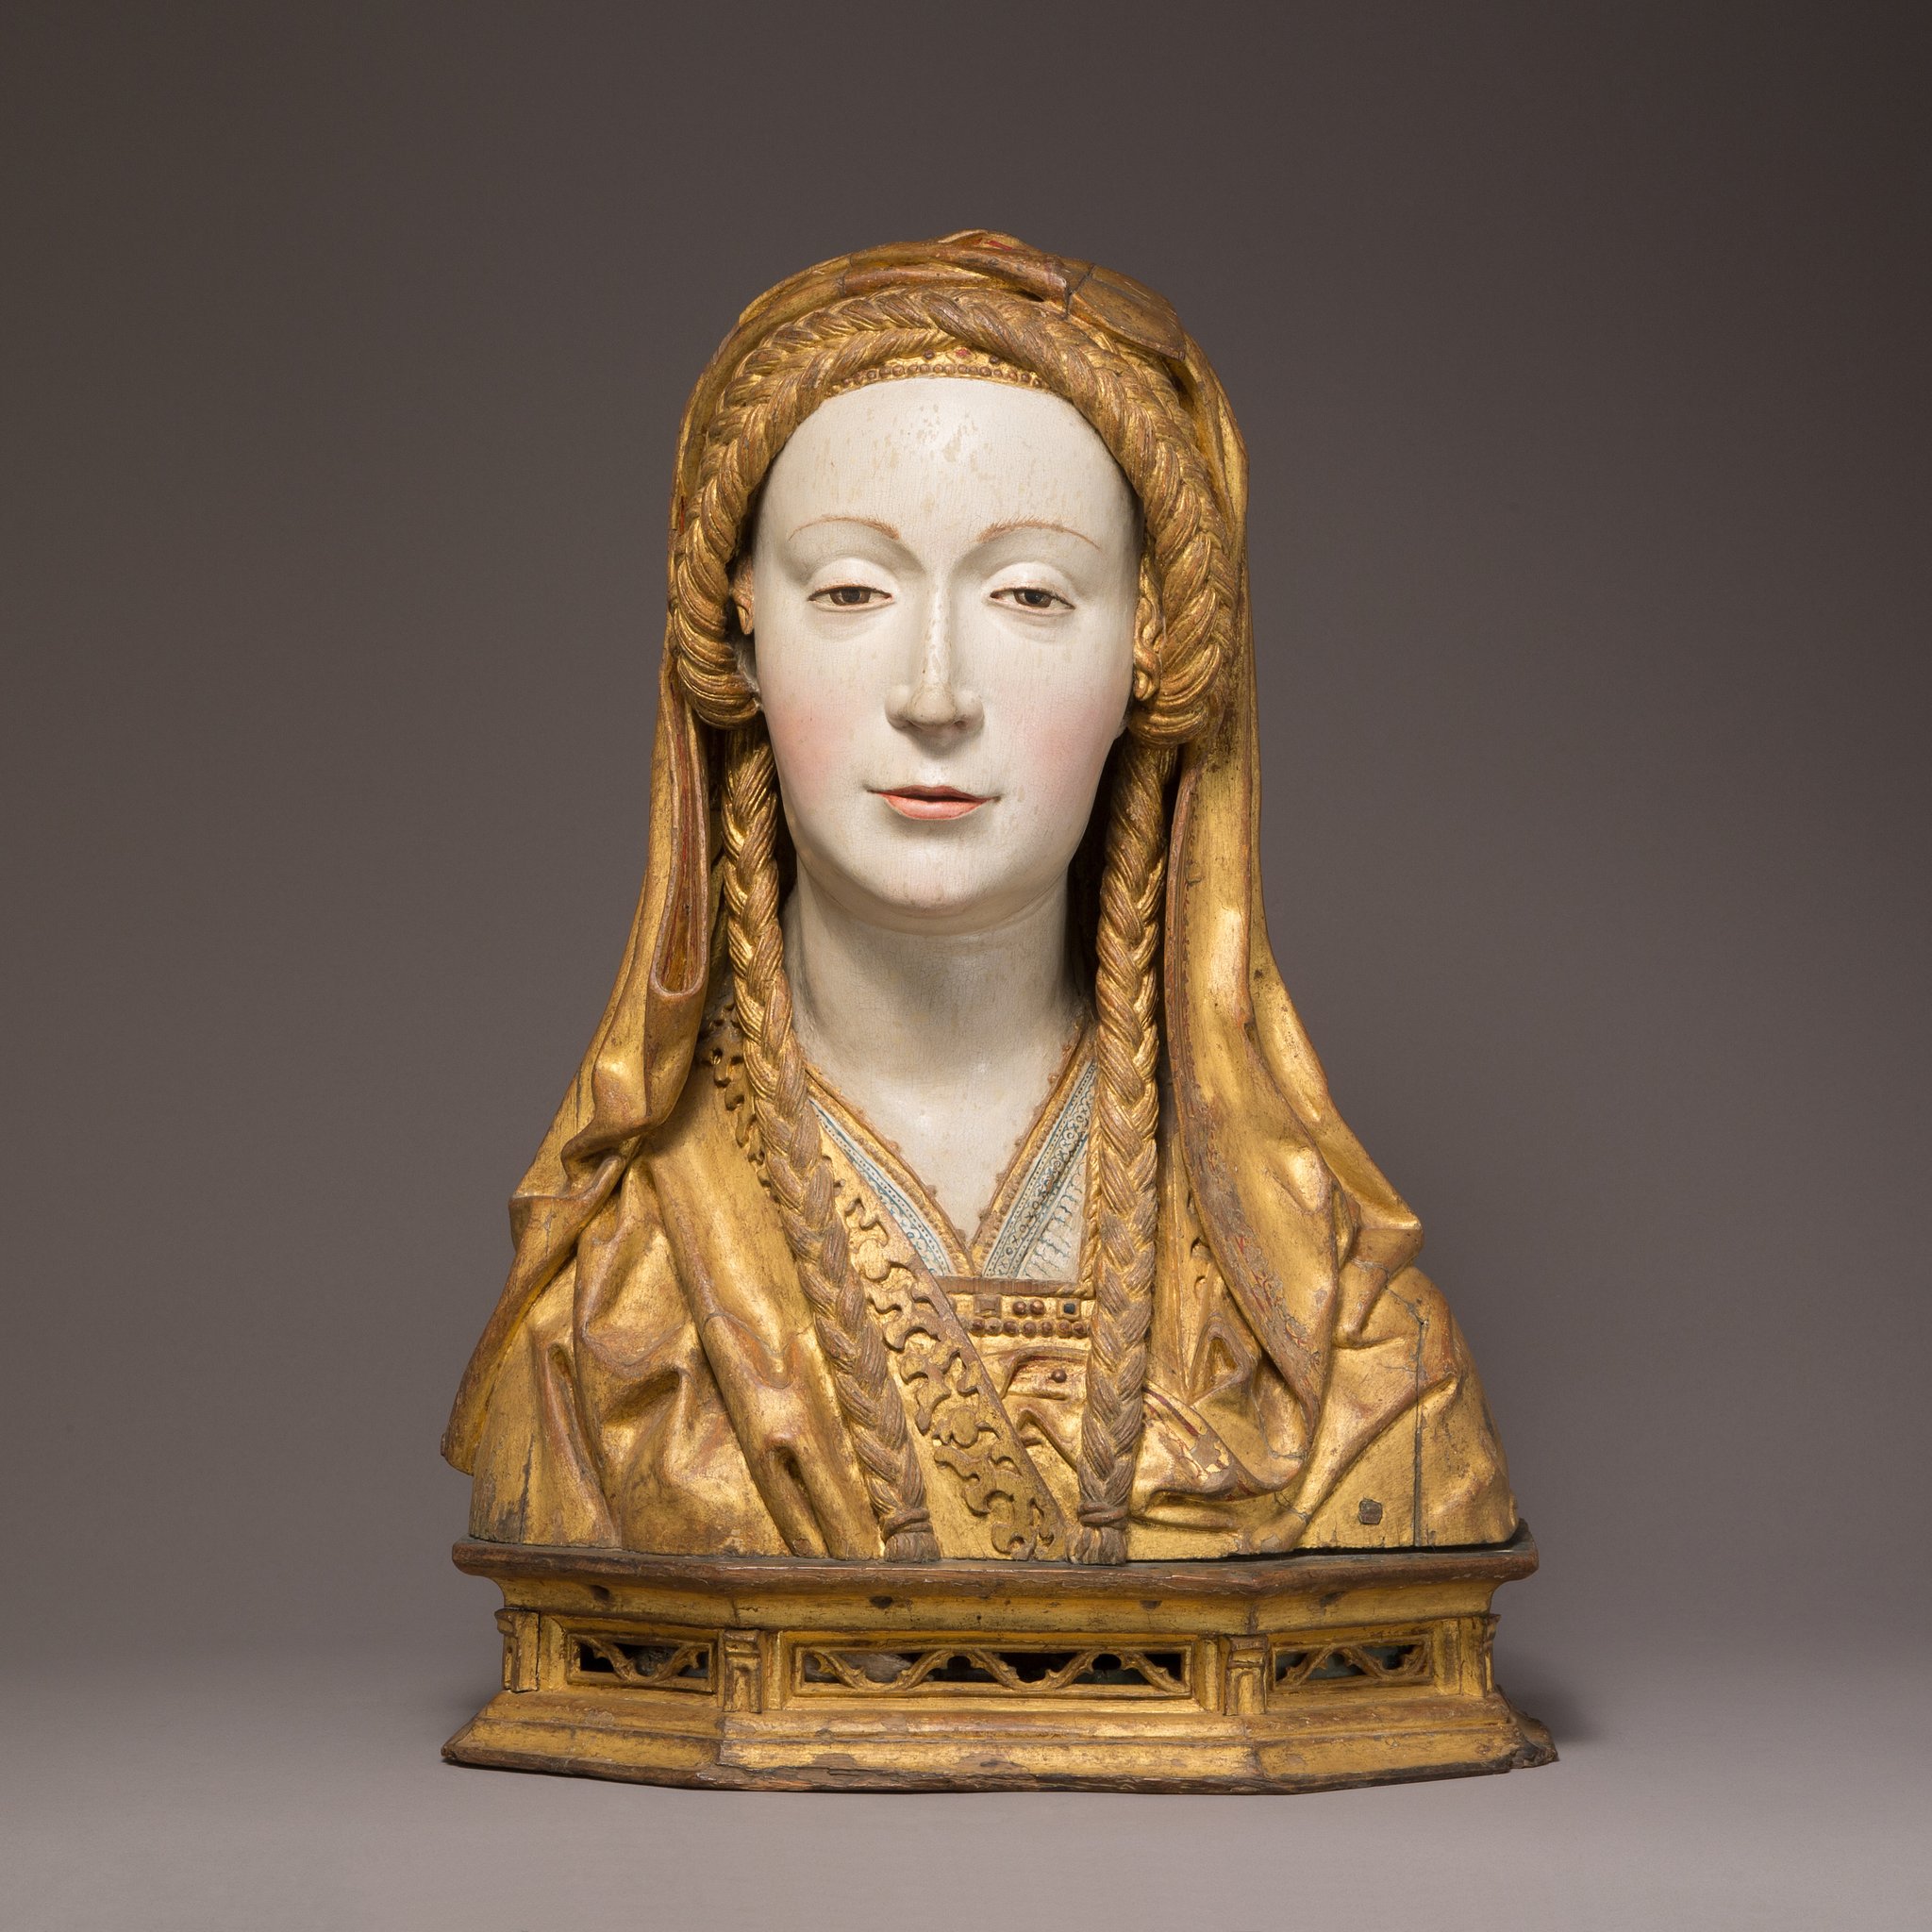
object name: reliquary bust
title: Reliquary Bust of a Female Saint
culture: south netherlandish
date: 1501-1533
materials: wood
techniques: gilding, painting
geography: south netherlands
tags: women,saints